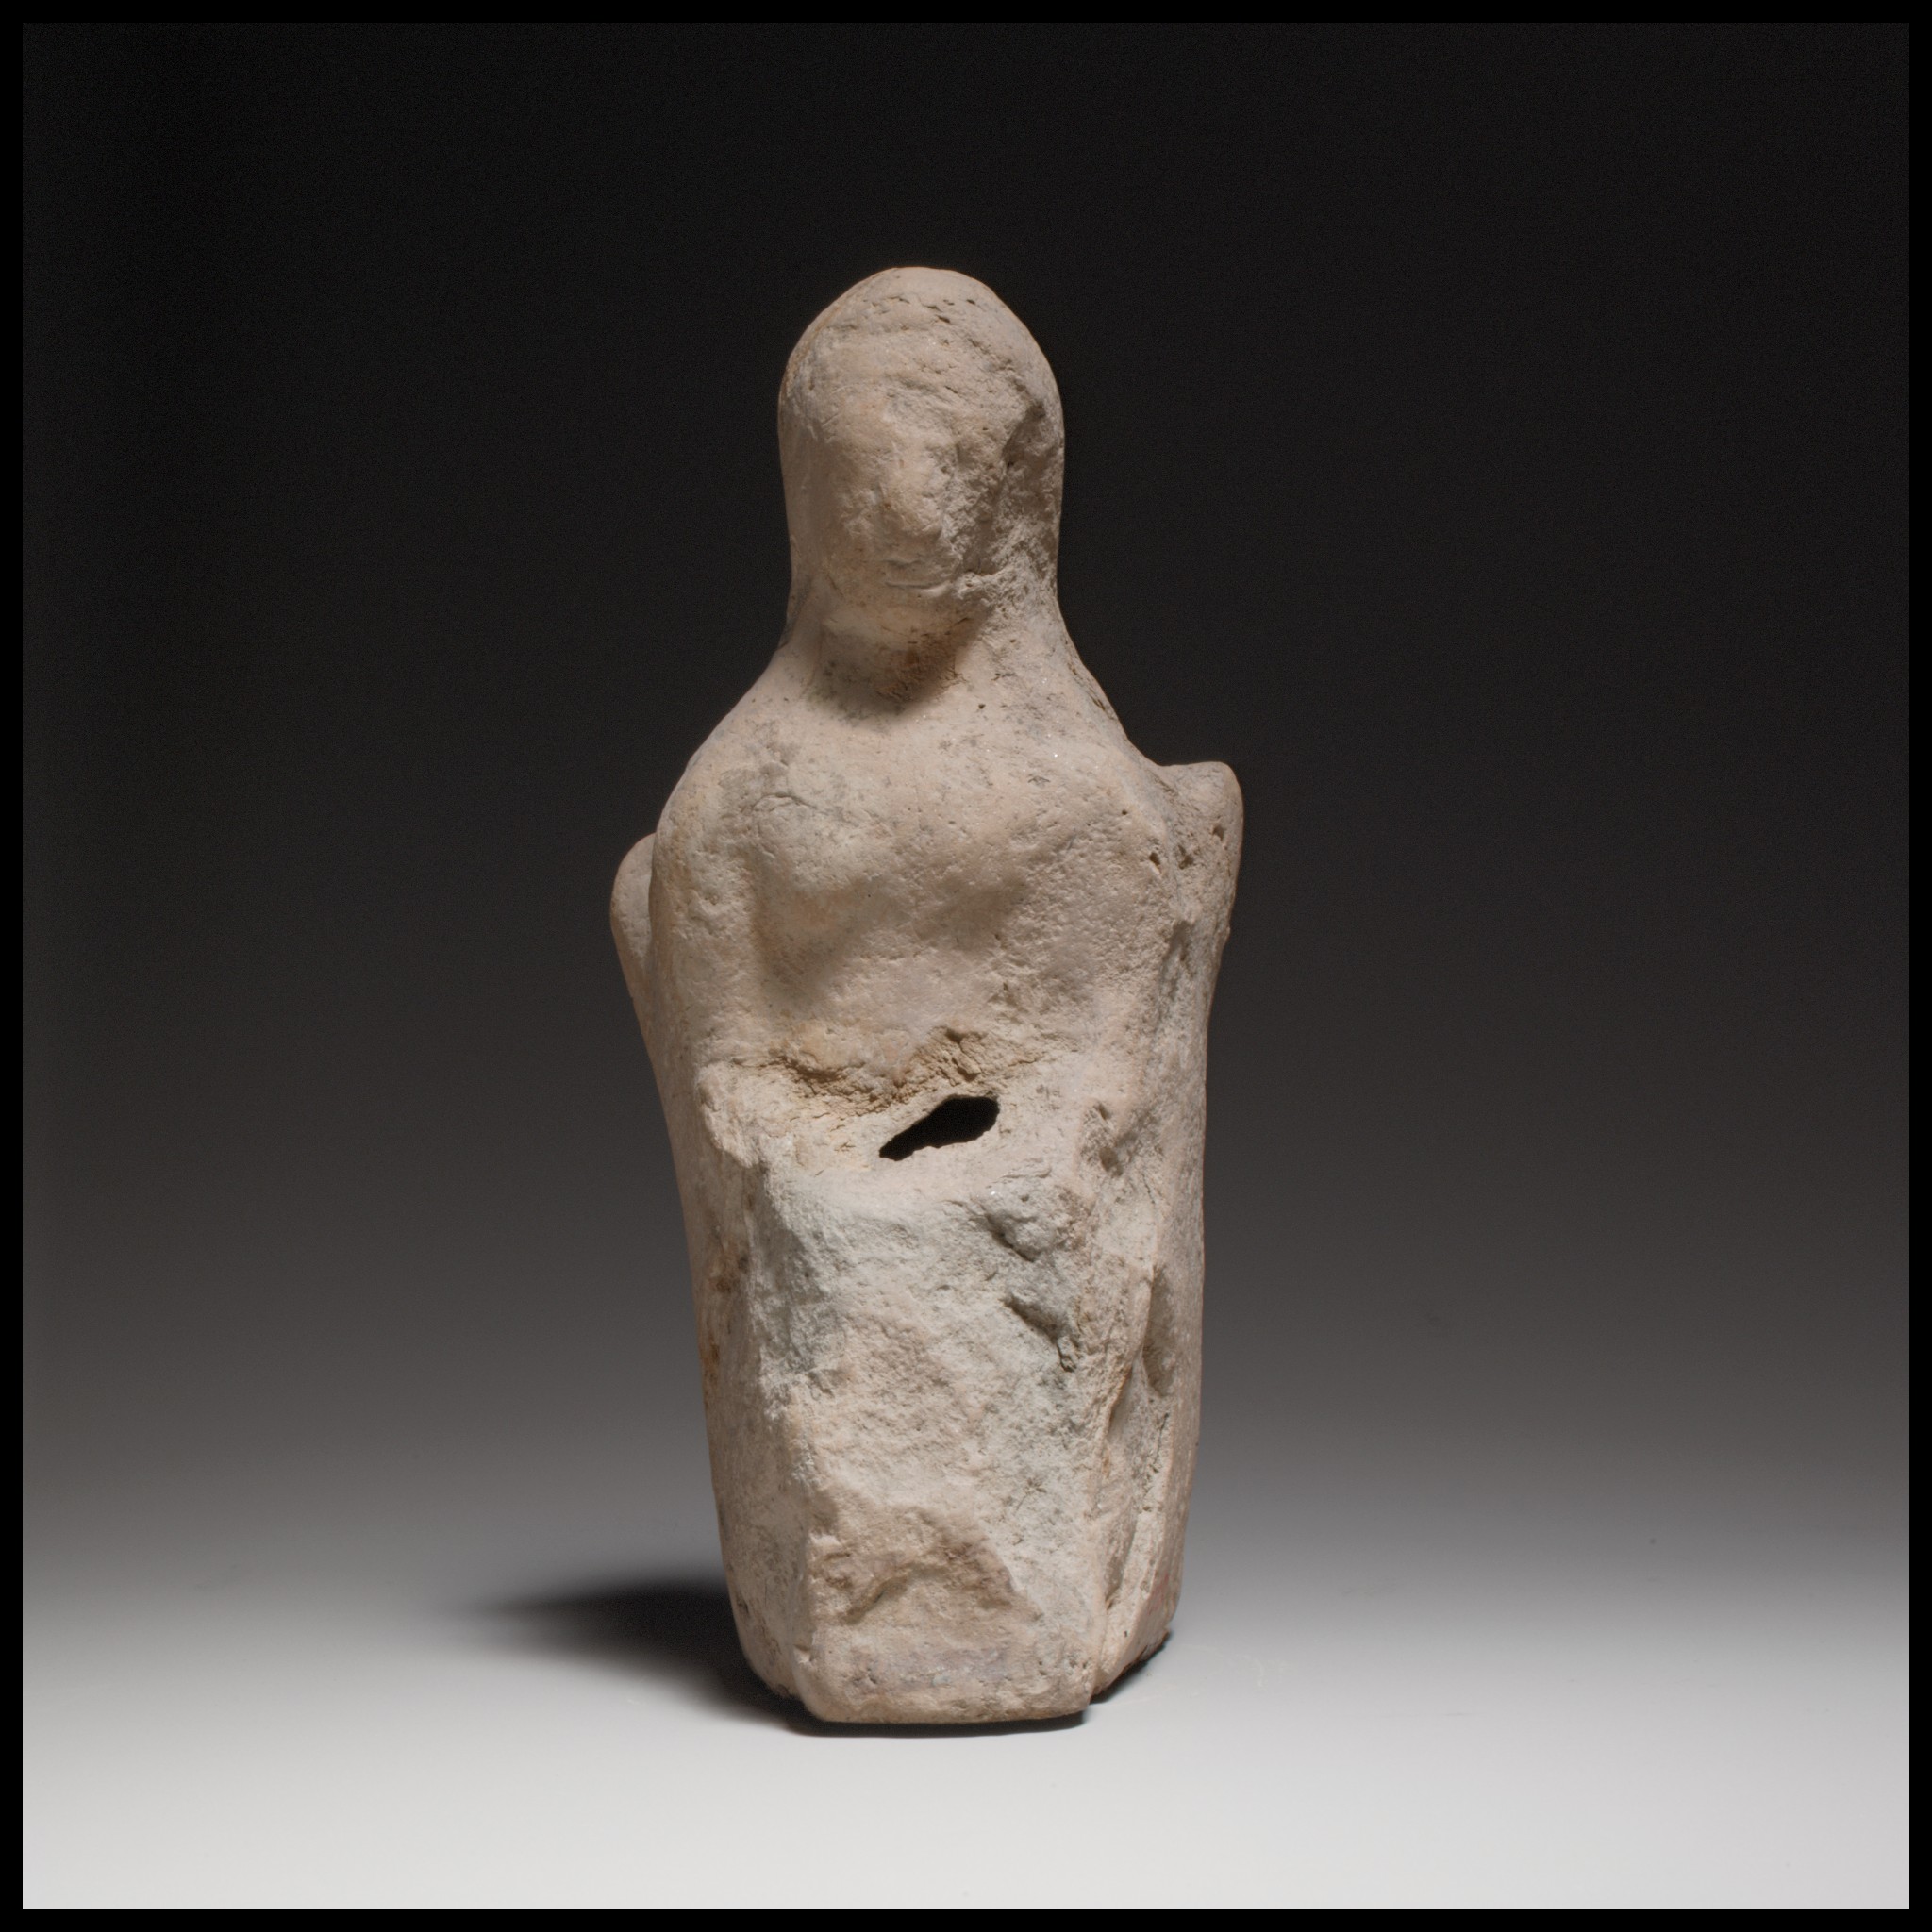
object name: statuette of a woman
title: Seated female figurine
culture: cypriot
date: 500-468 BCE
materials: terracotta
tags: women